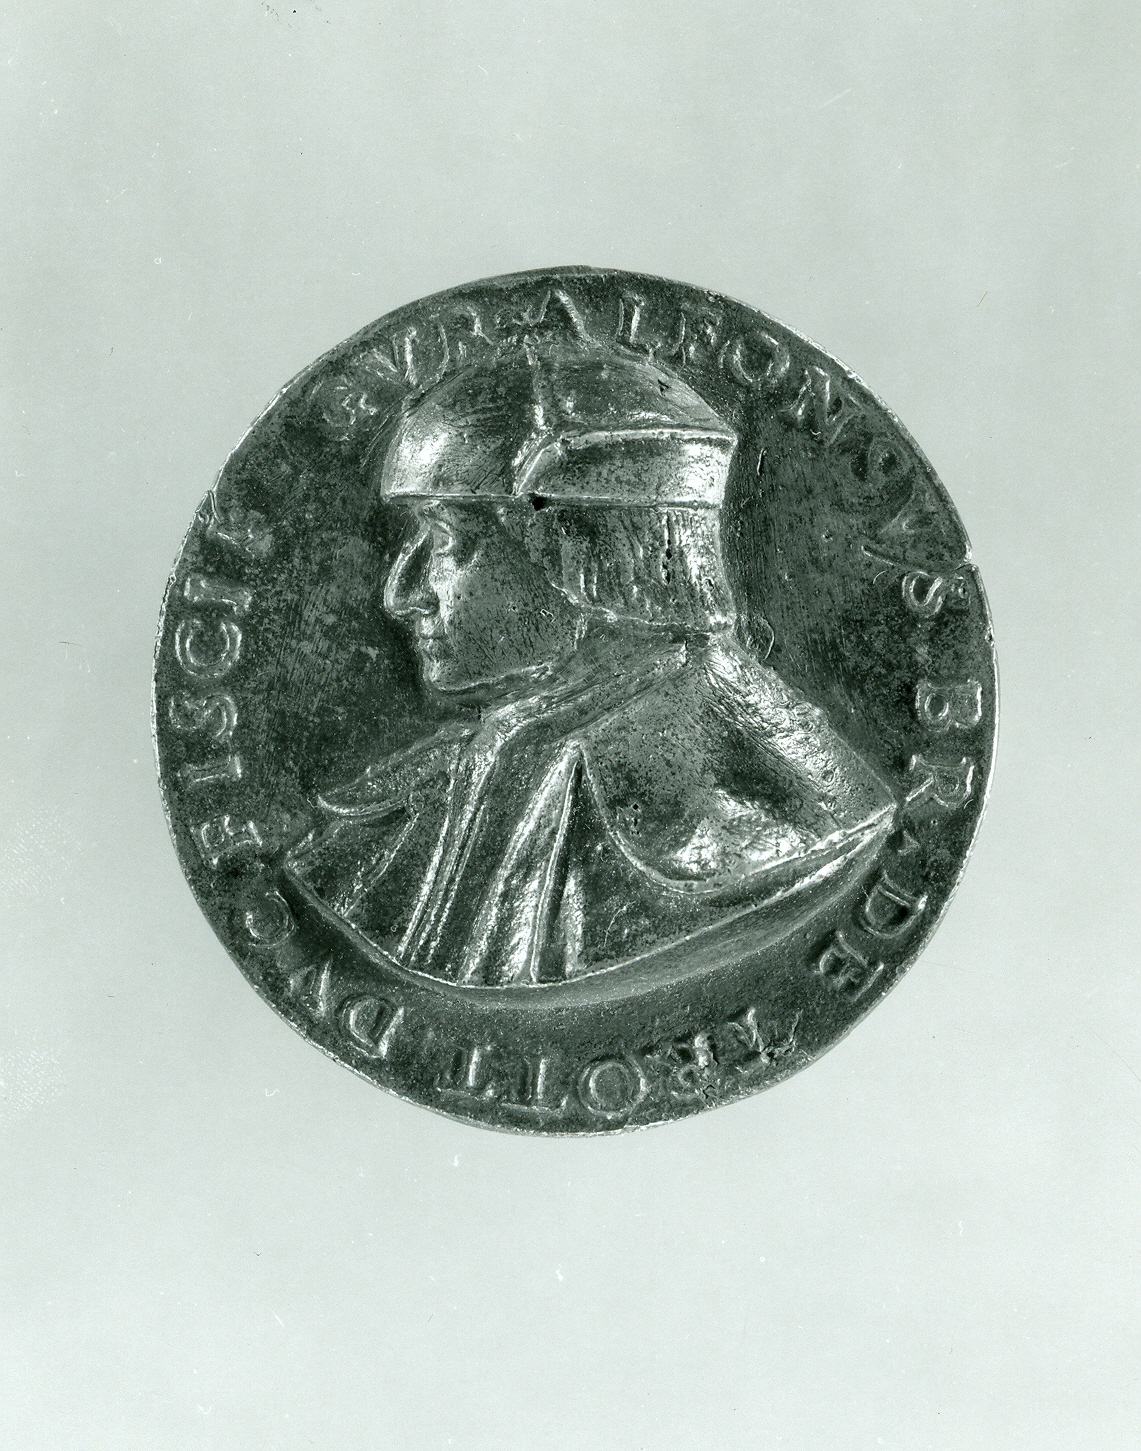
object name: medal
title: Medal: Alfonso de Brandeligi Trotti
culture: italian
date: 1520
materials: bronze, copper alloy, lacquer, patina, wax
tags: men,portraits